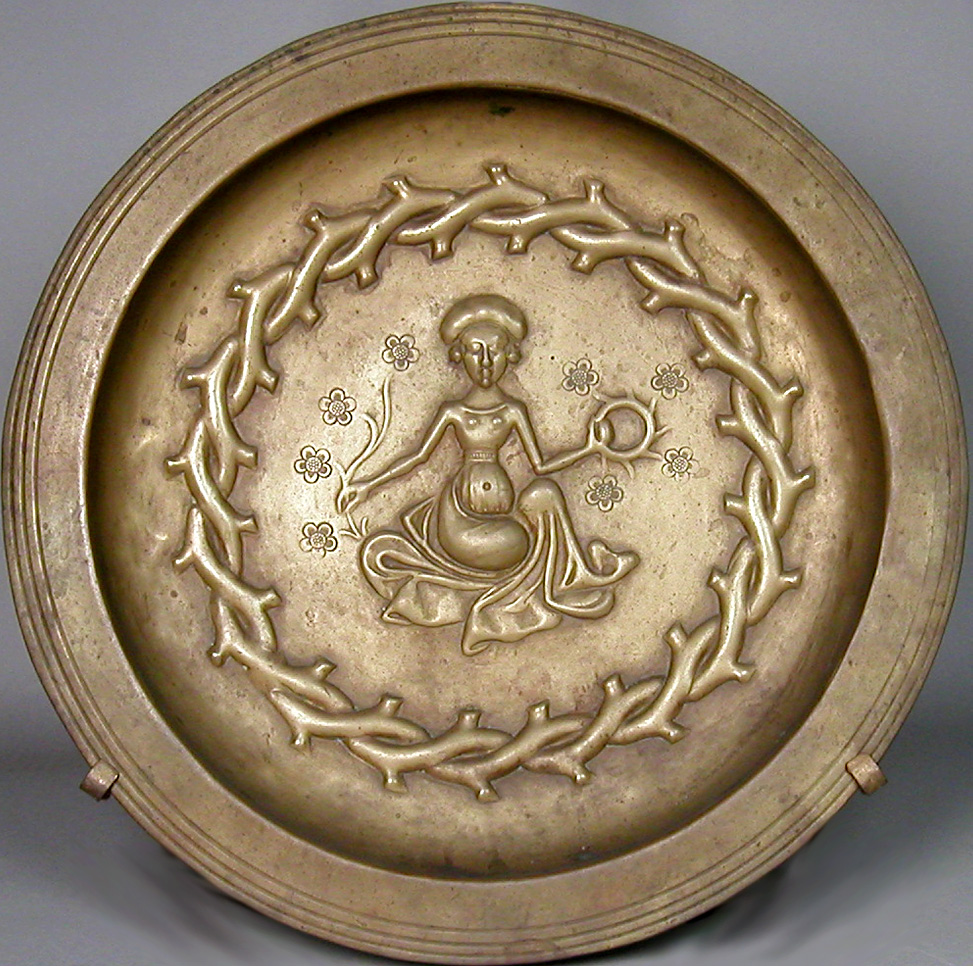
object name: dish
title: Plate with Seated Woman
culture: south netherlandish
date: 1450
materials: copper alloy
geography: dinant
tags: women,flowers